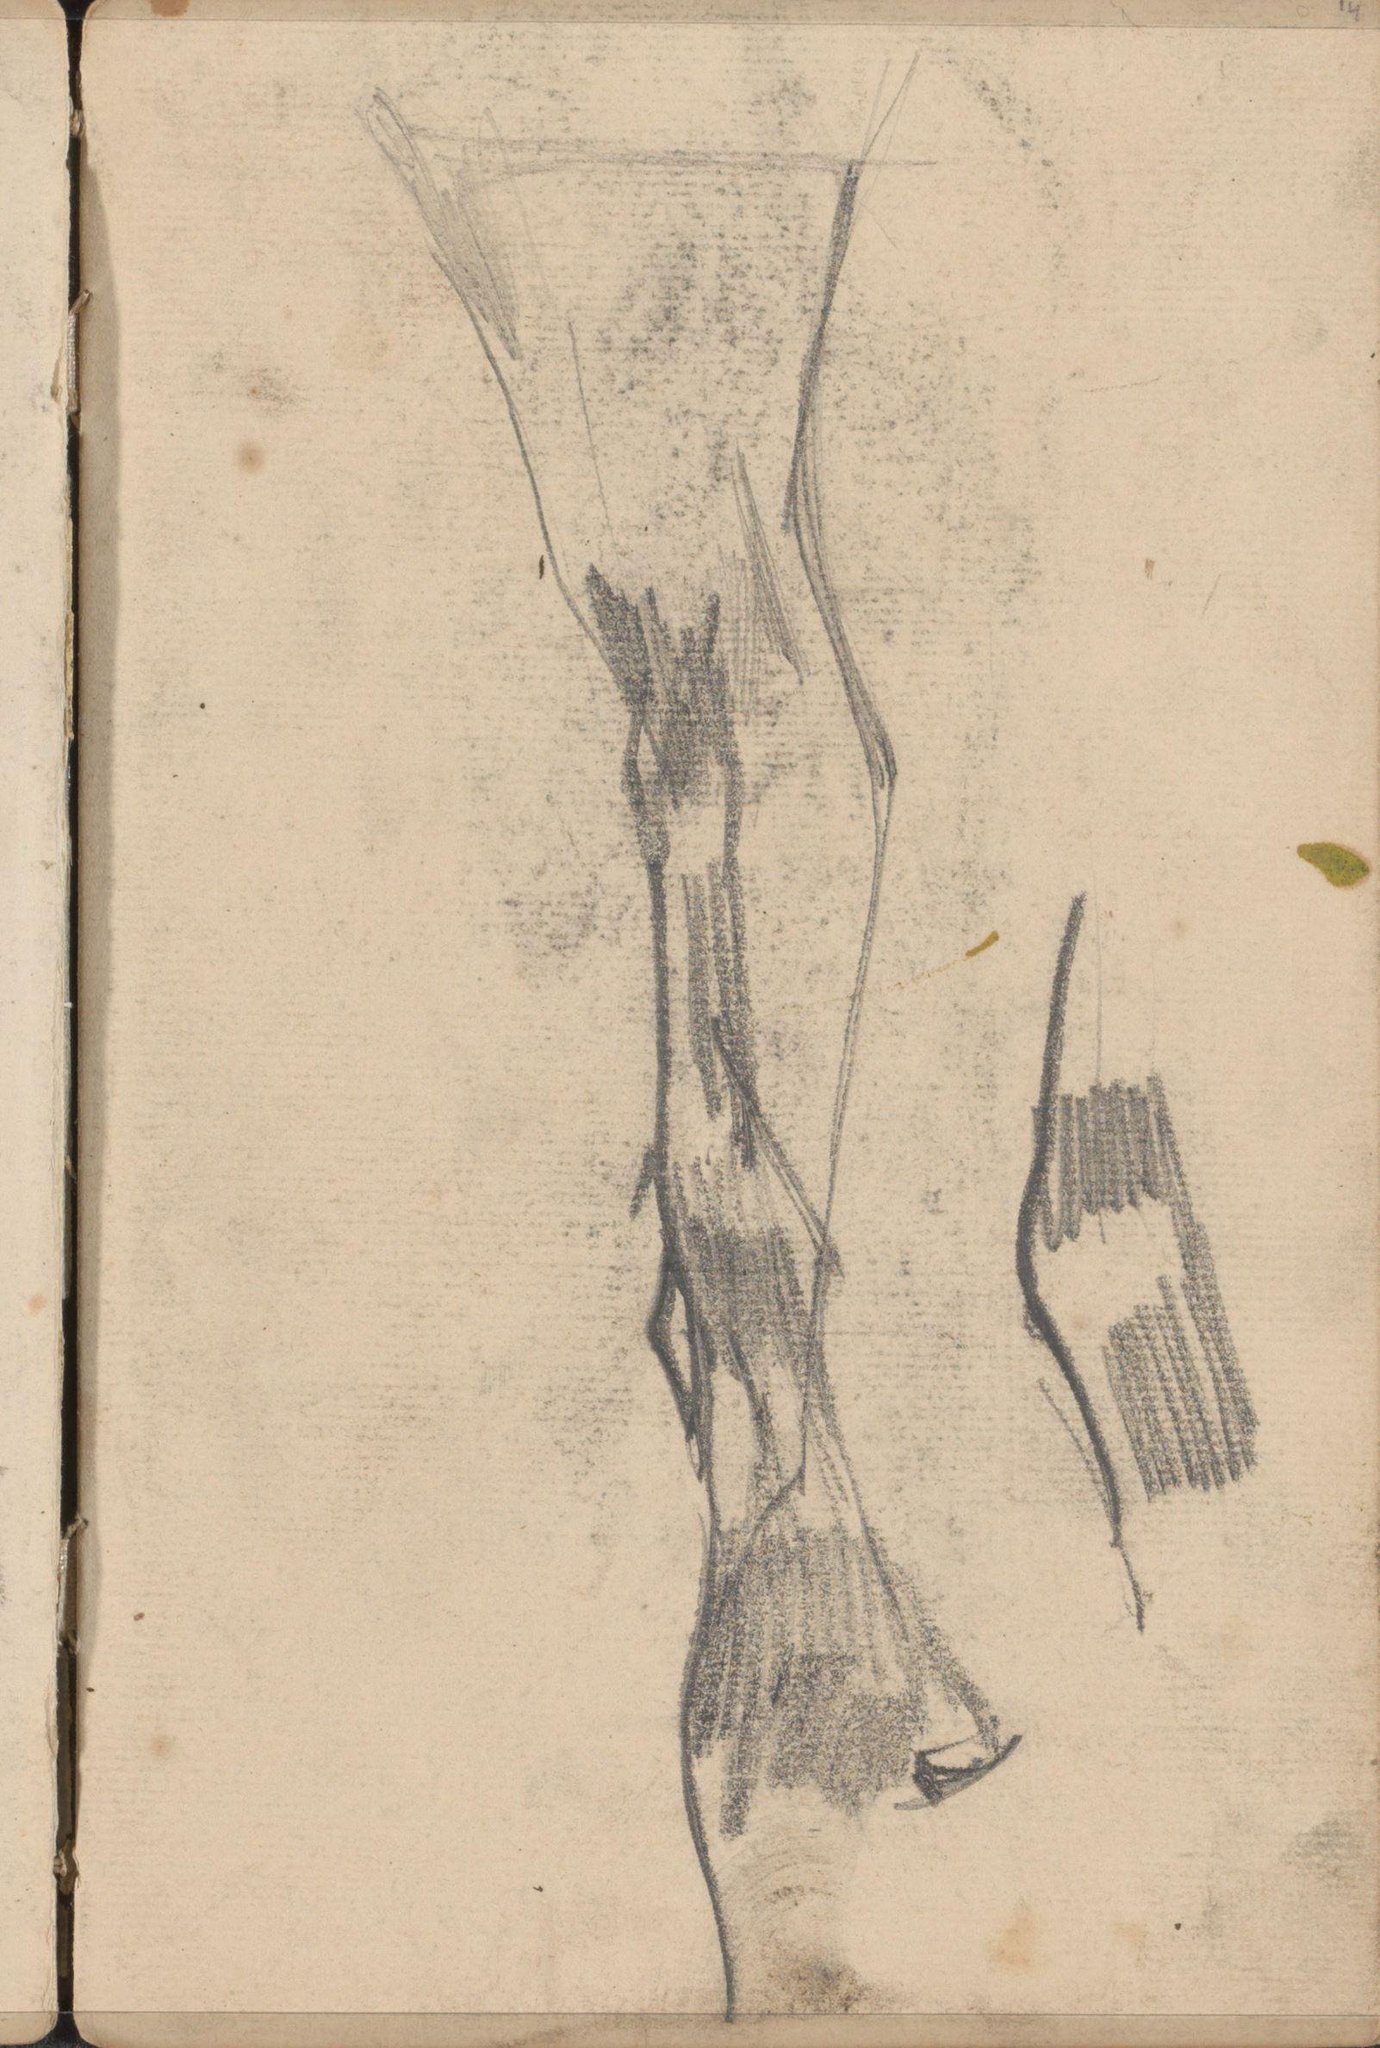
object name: sketchbook leaf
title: Paardenbenen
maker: george hendrik breitner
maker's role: draughtsman, painter, print maker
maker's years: 1857-1923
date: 1887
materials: paper, pencil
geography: amsterdam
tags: horse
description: Pagina 14 uit een schetsboek met 12 bladen.